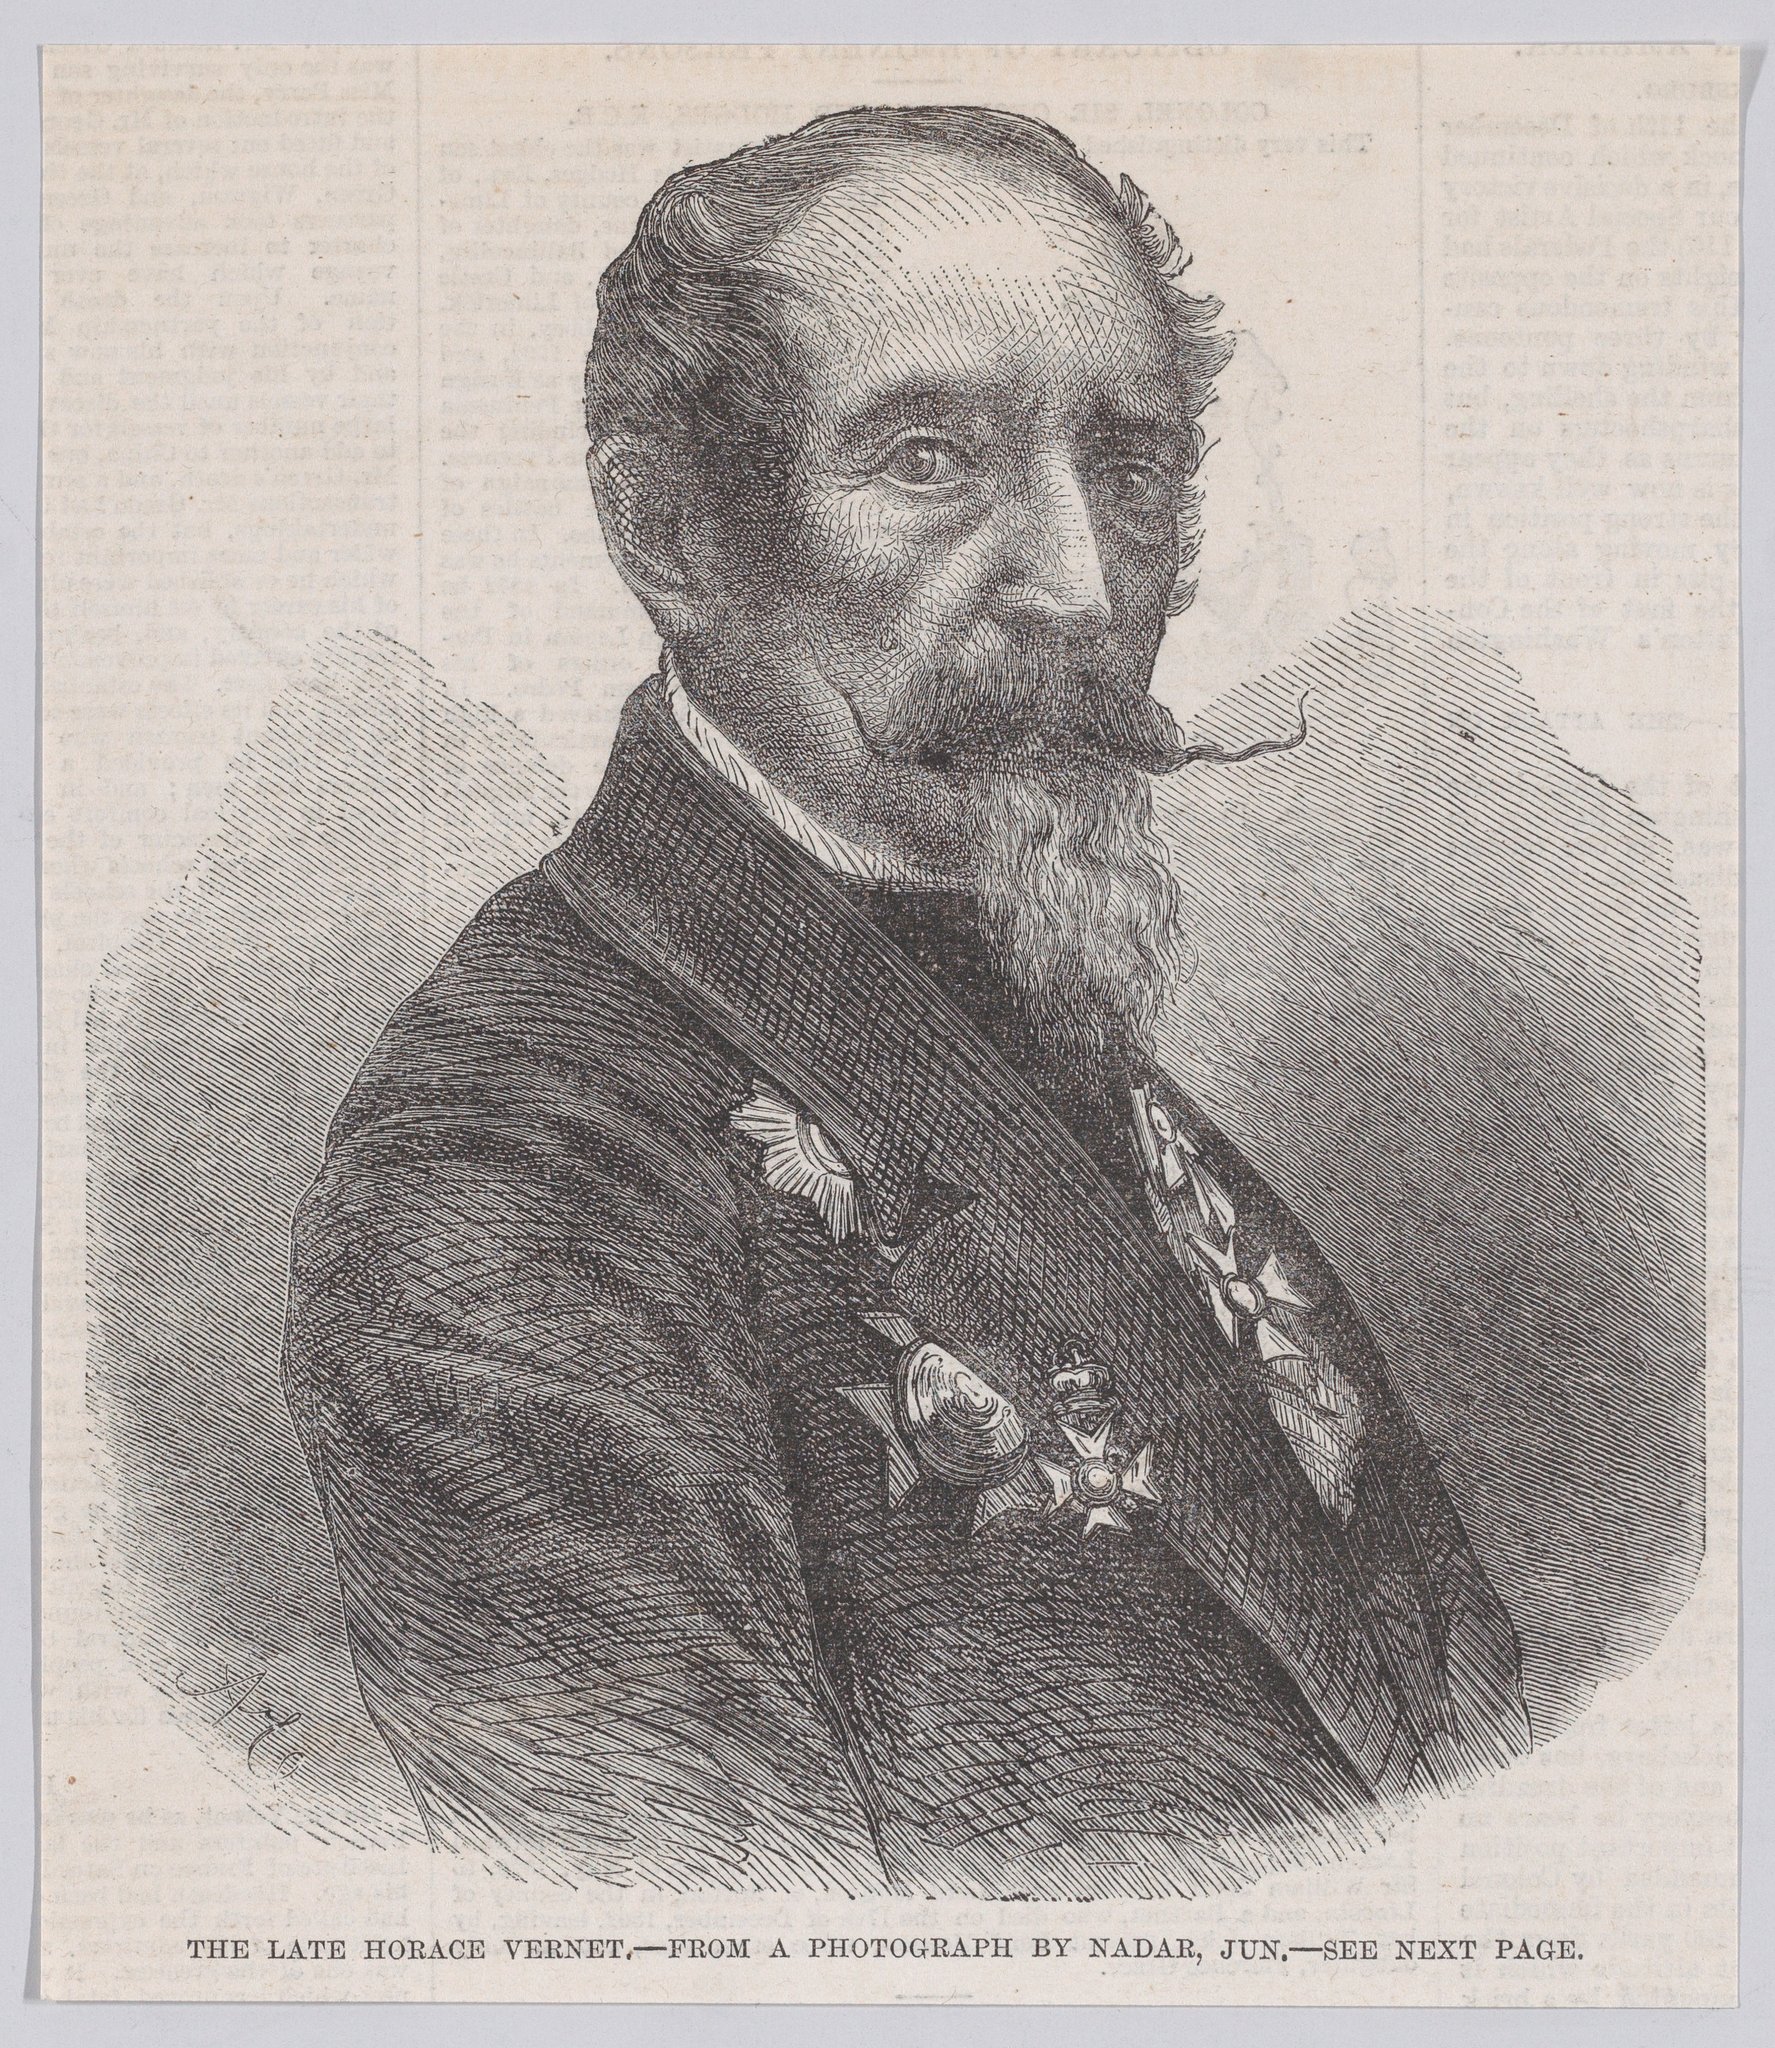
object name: print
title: The Late Horace Vernet, from "Illustrated London News"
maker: félix nadar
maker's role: artist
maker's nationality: french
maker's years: 1820-1910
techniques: engraving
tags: men,portraits,artists